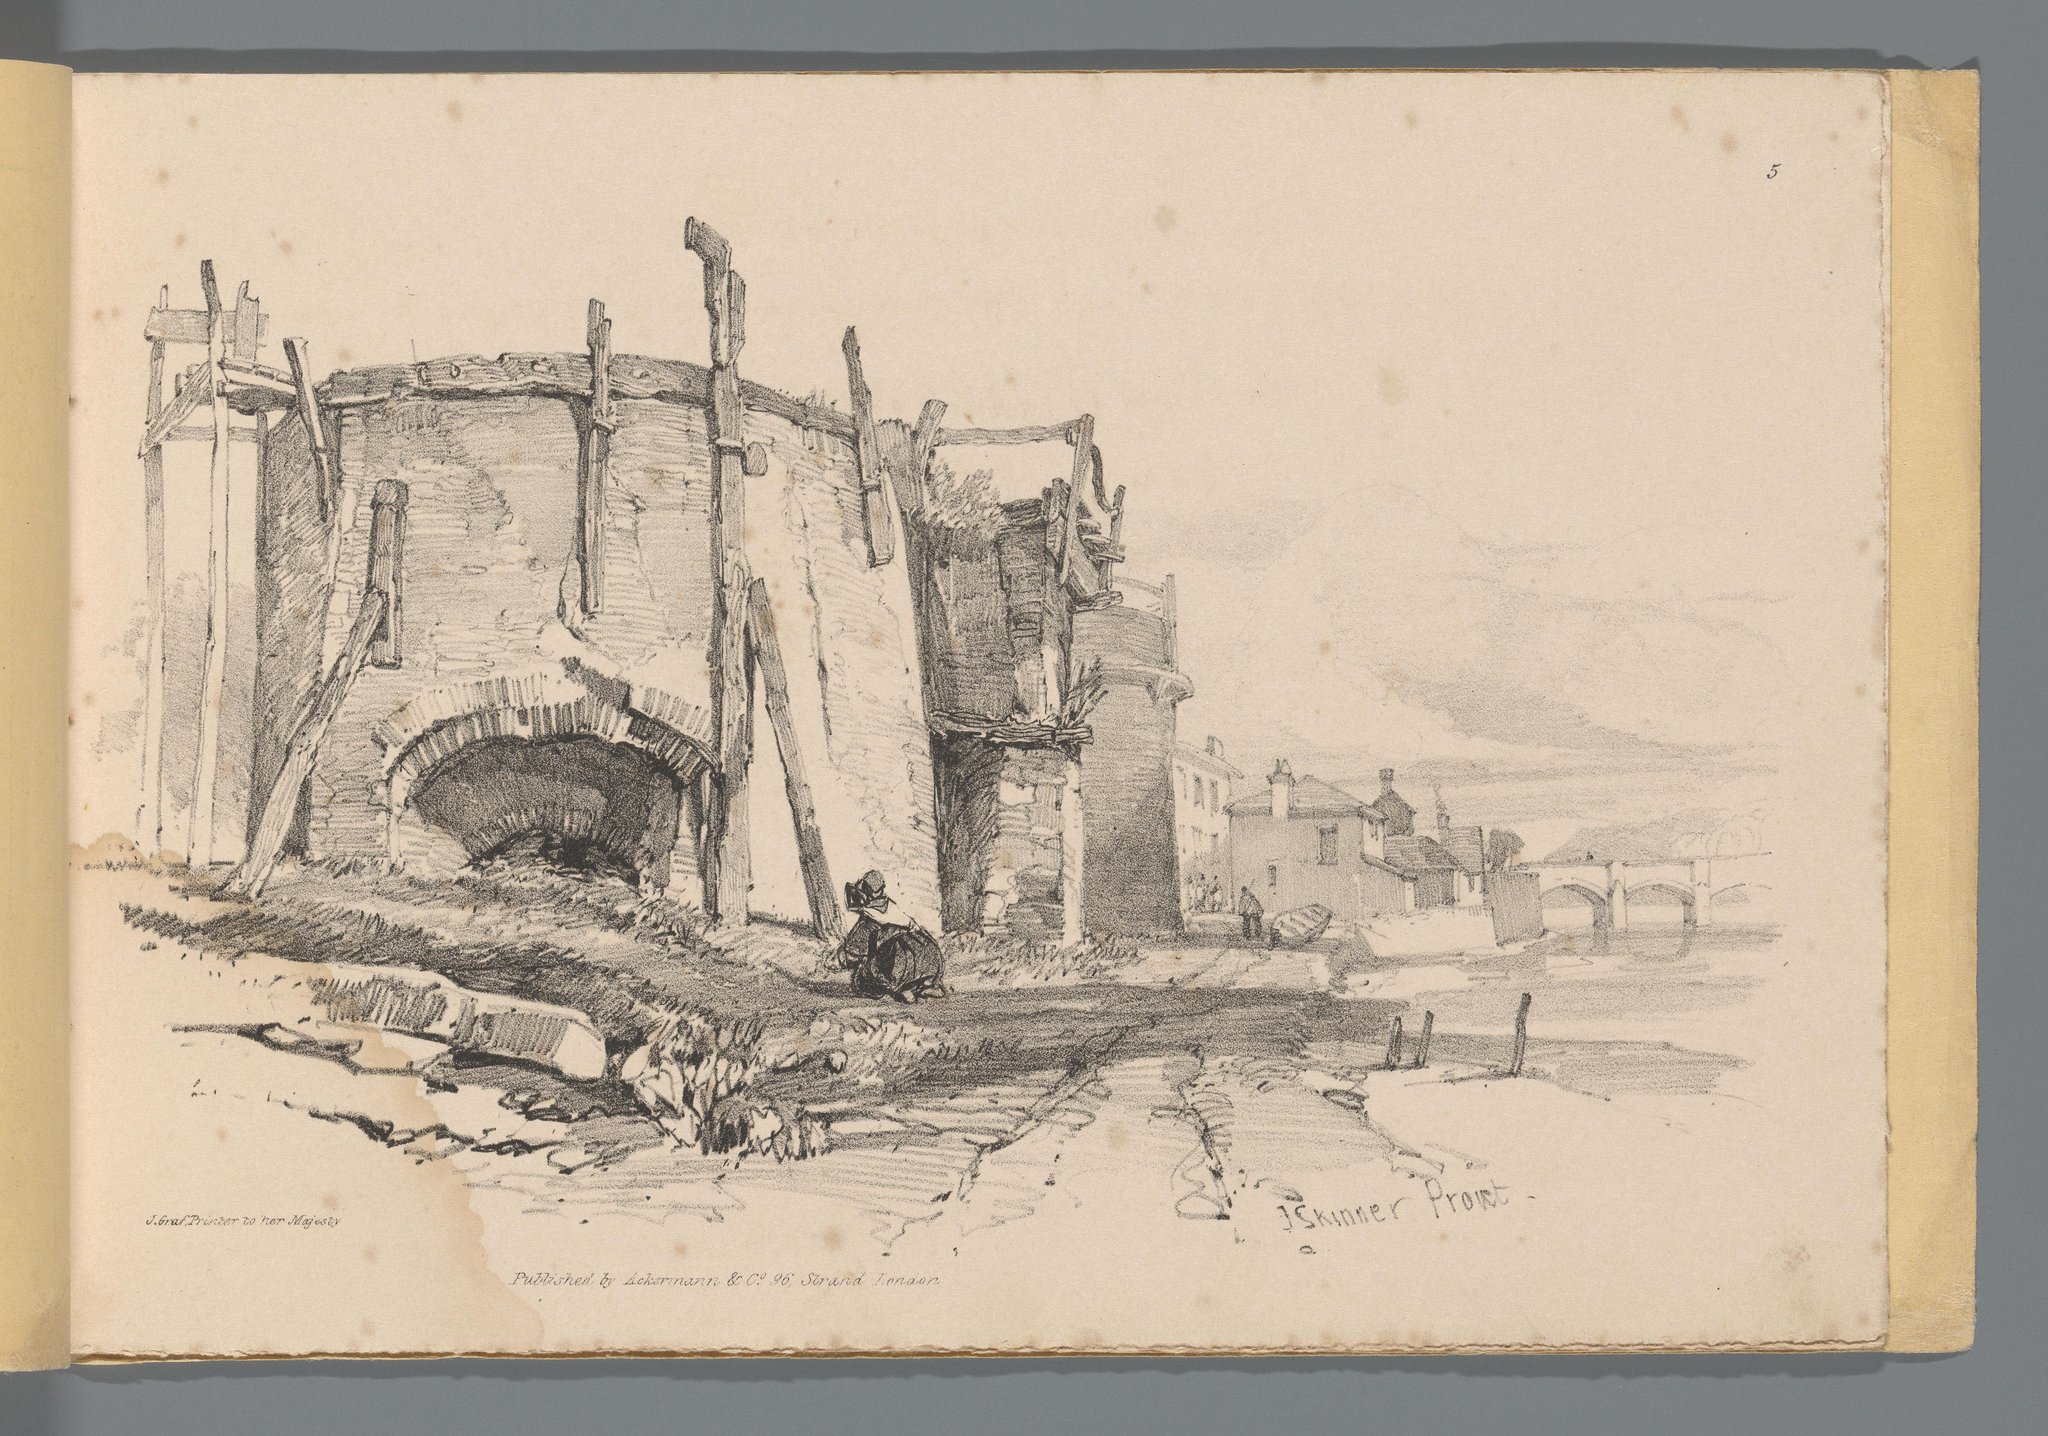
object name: print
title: Landschap met bebouwing aan het water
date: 1839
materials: paper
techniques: lithograph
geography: london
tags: bridge in city across river, canal, etc., landscapes in the temperate zone (+ landscape with figures, staffage)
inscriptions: collector's mark: Lugt 2228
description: Prent behoort tot de serie 'Ackermann's new drawing-book, for the year 1839, by J. Skinner Prout'. Deze serie is uitgegeven in zes delen met elk vier lithografieën.